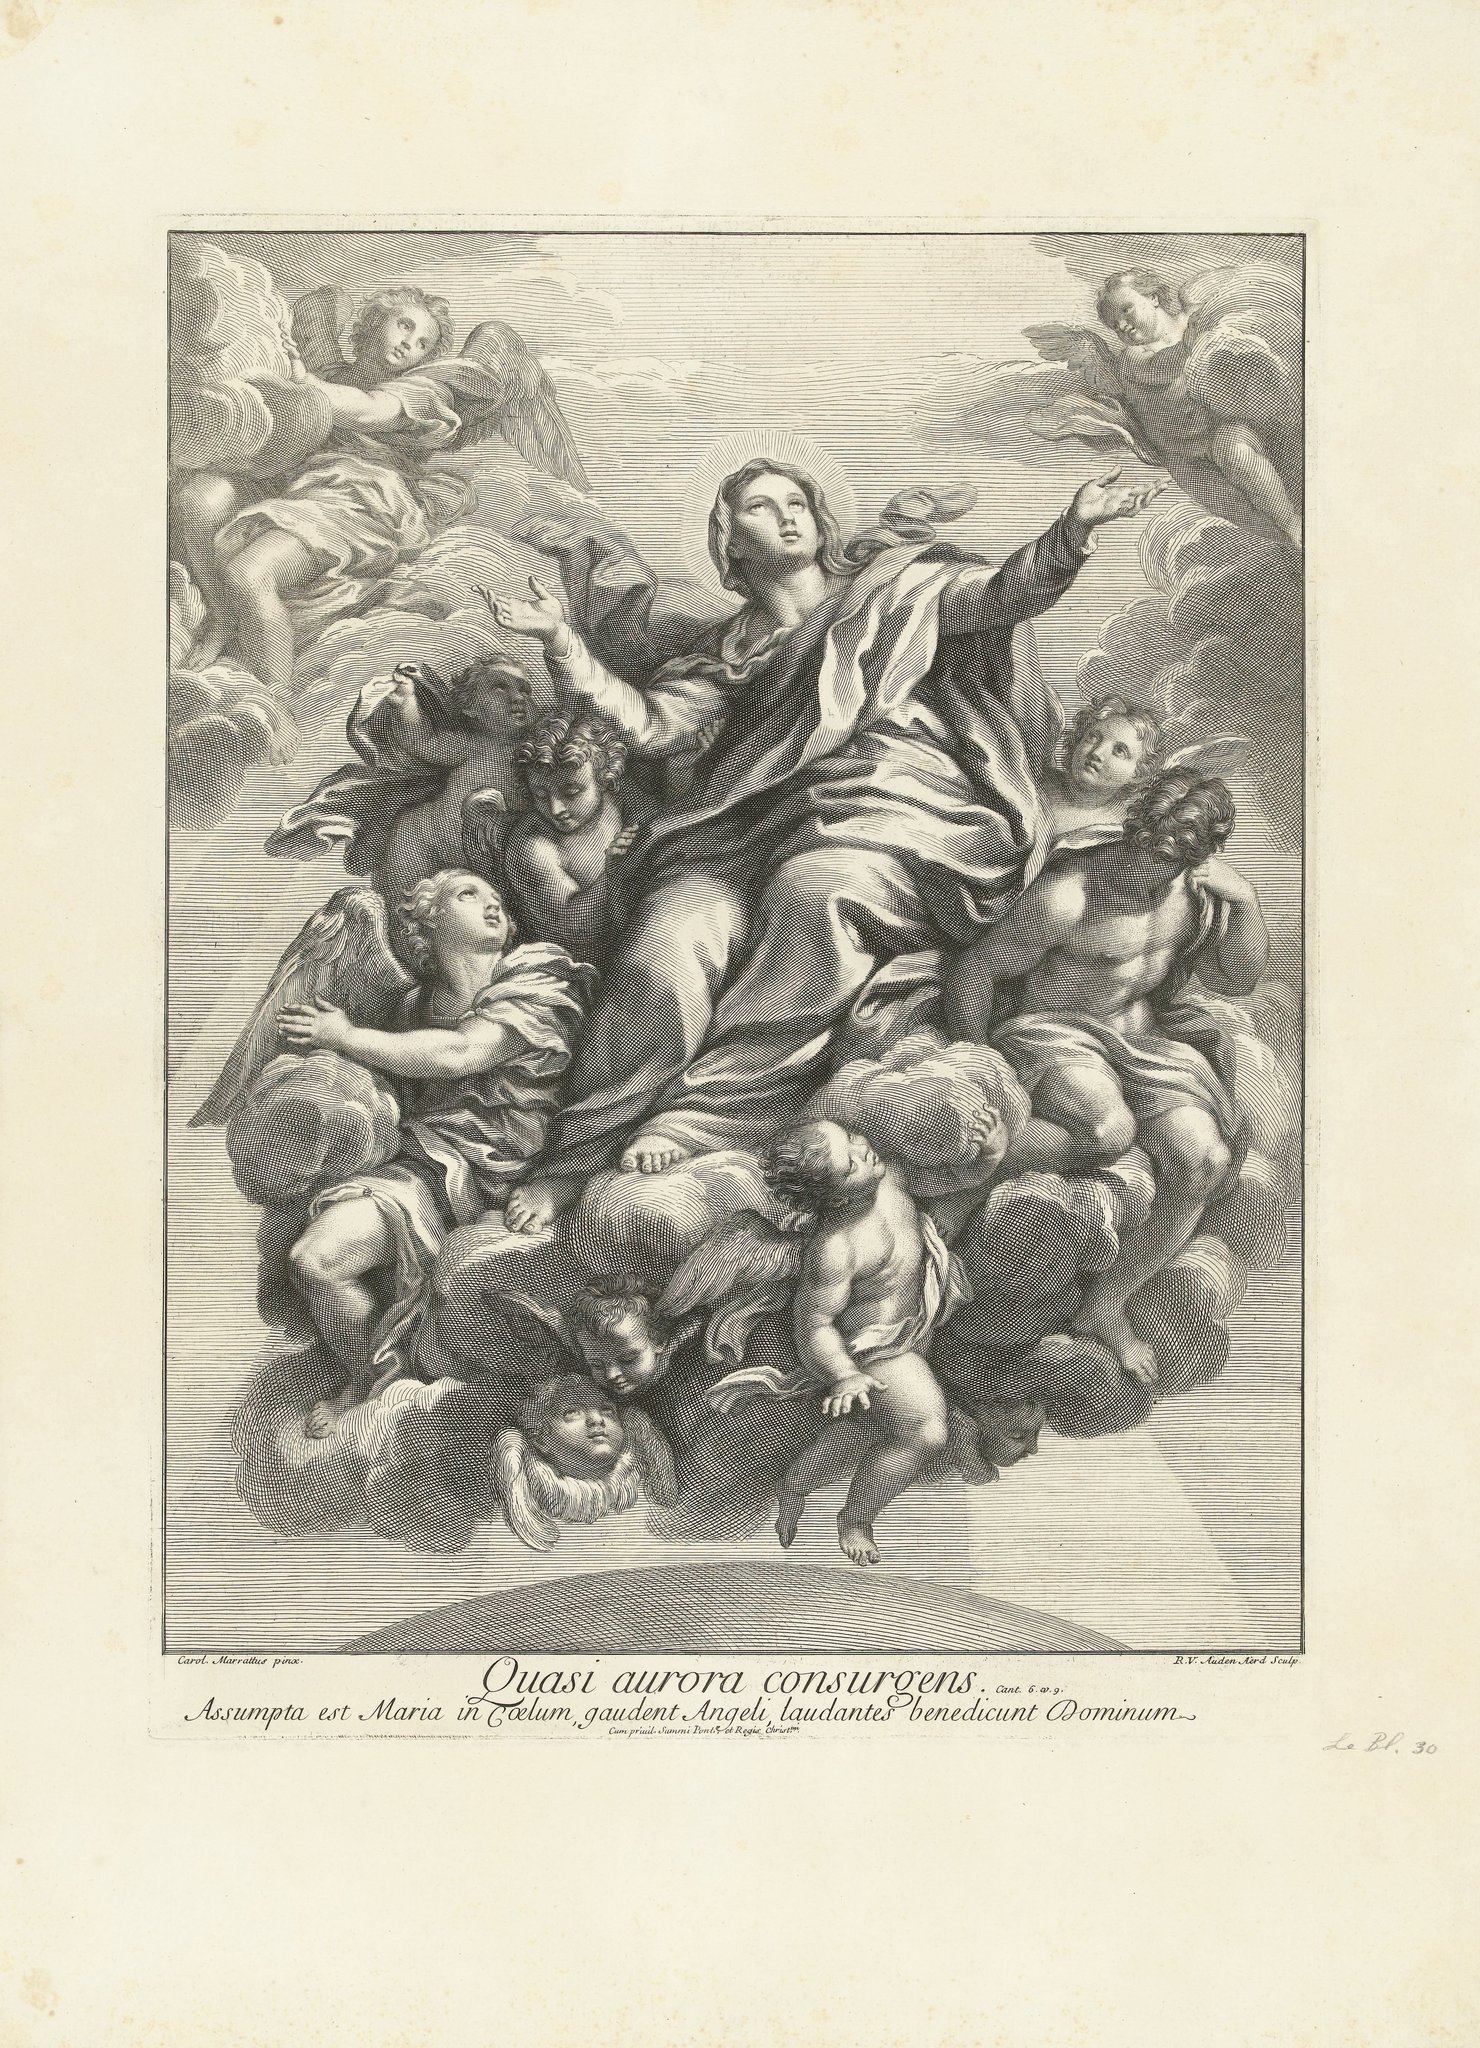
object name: print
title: Maria Hemelvaart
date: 1685-1723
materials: paper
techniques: engraving, etching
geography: rome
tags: the assumption of mary ('assumptio corporis'): she is borne into heaven by angels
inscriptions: collector's mark: Lugt 240